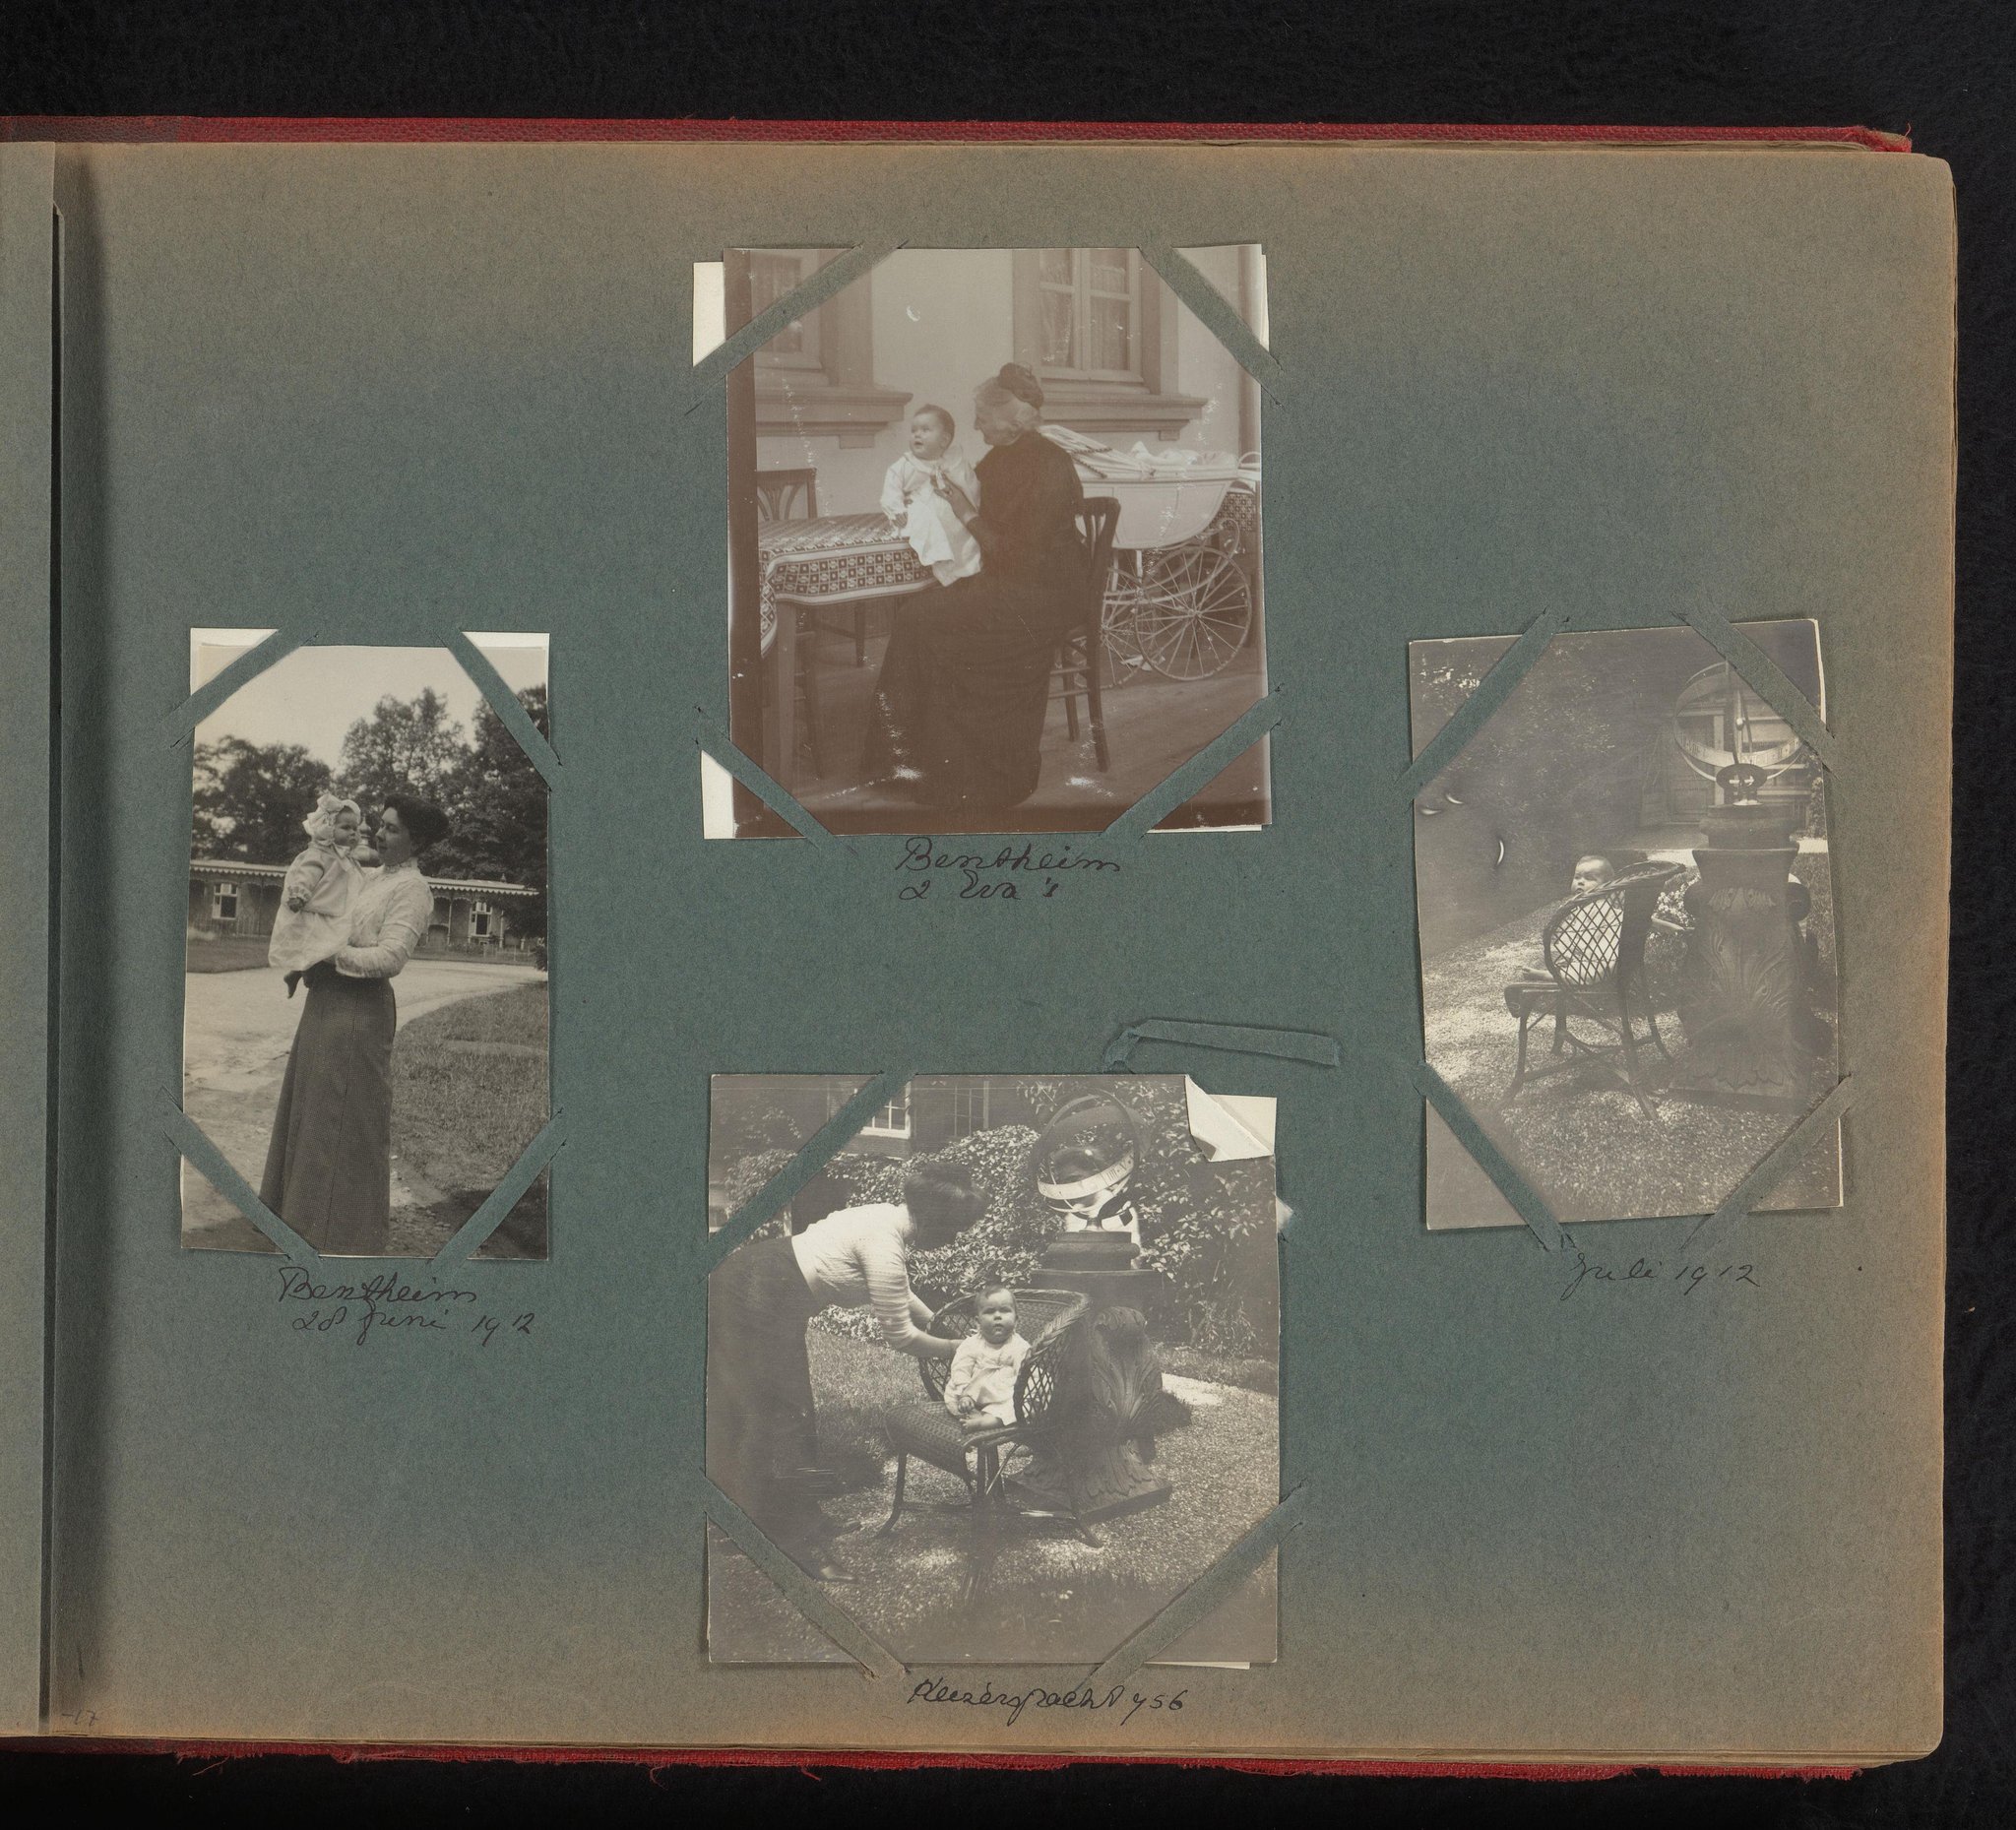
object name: photograph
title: Eva Boelen met familieleden, waaronder Charlotte Boelen-Matthes, Charlotte Matthes-Doorman en Eva Boelen-Smidt van Gelder, in de tuin van Keizersgracht 756 en in Bad Bentheim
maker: charlotte alida boelen-matthes (lot)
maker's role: amateurfotograaf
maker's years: 1889-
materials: paper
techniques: gelatin silver print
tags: amsterdam, eva charlotte pennink-boelen, charlotte alida boelen-matthes (lot), child(ren) with other members of the family, garden, infant, baby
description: Deze foto's zijn onderdeel van een album.